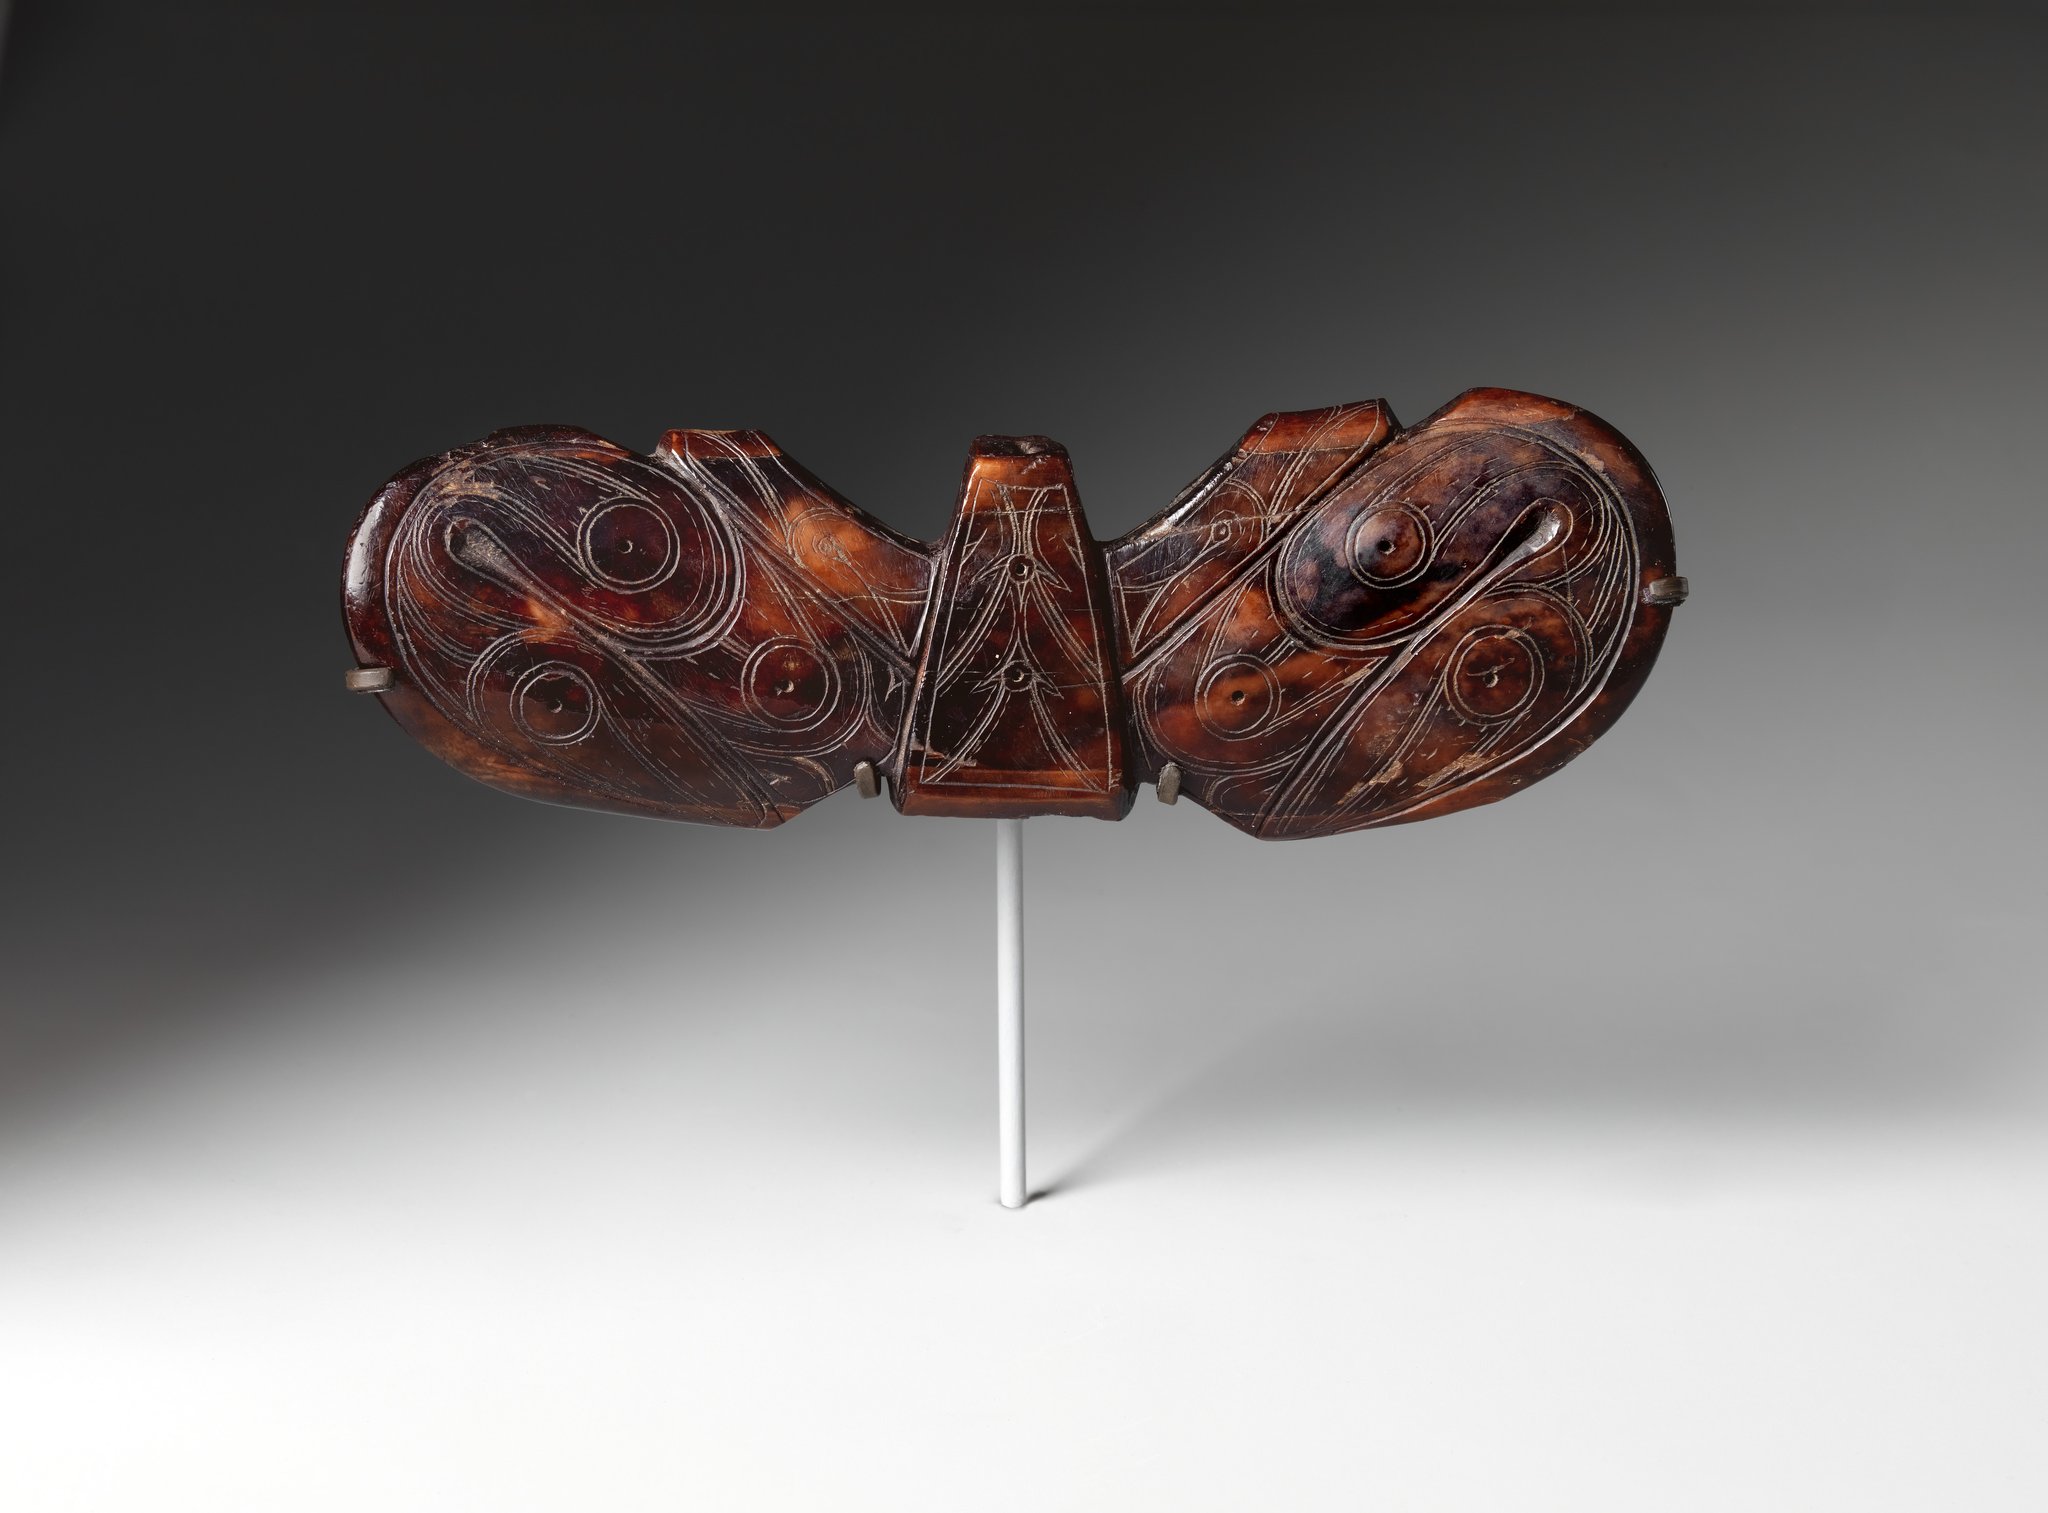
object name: harpoon counterweight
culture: old bering sea iii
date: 300-500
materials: ivory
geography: united states